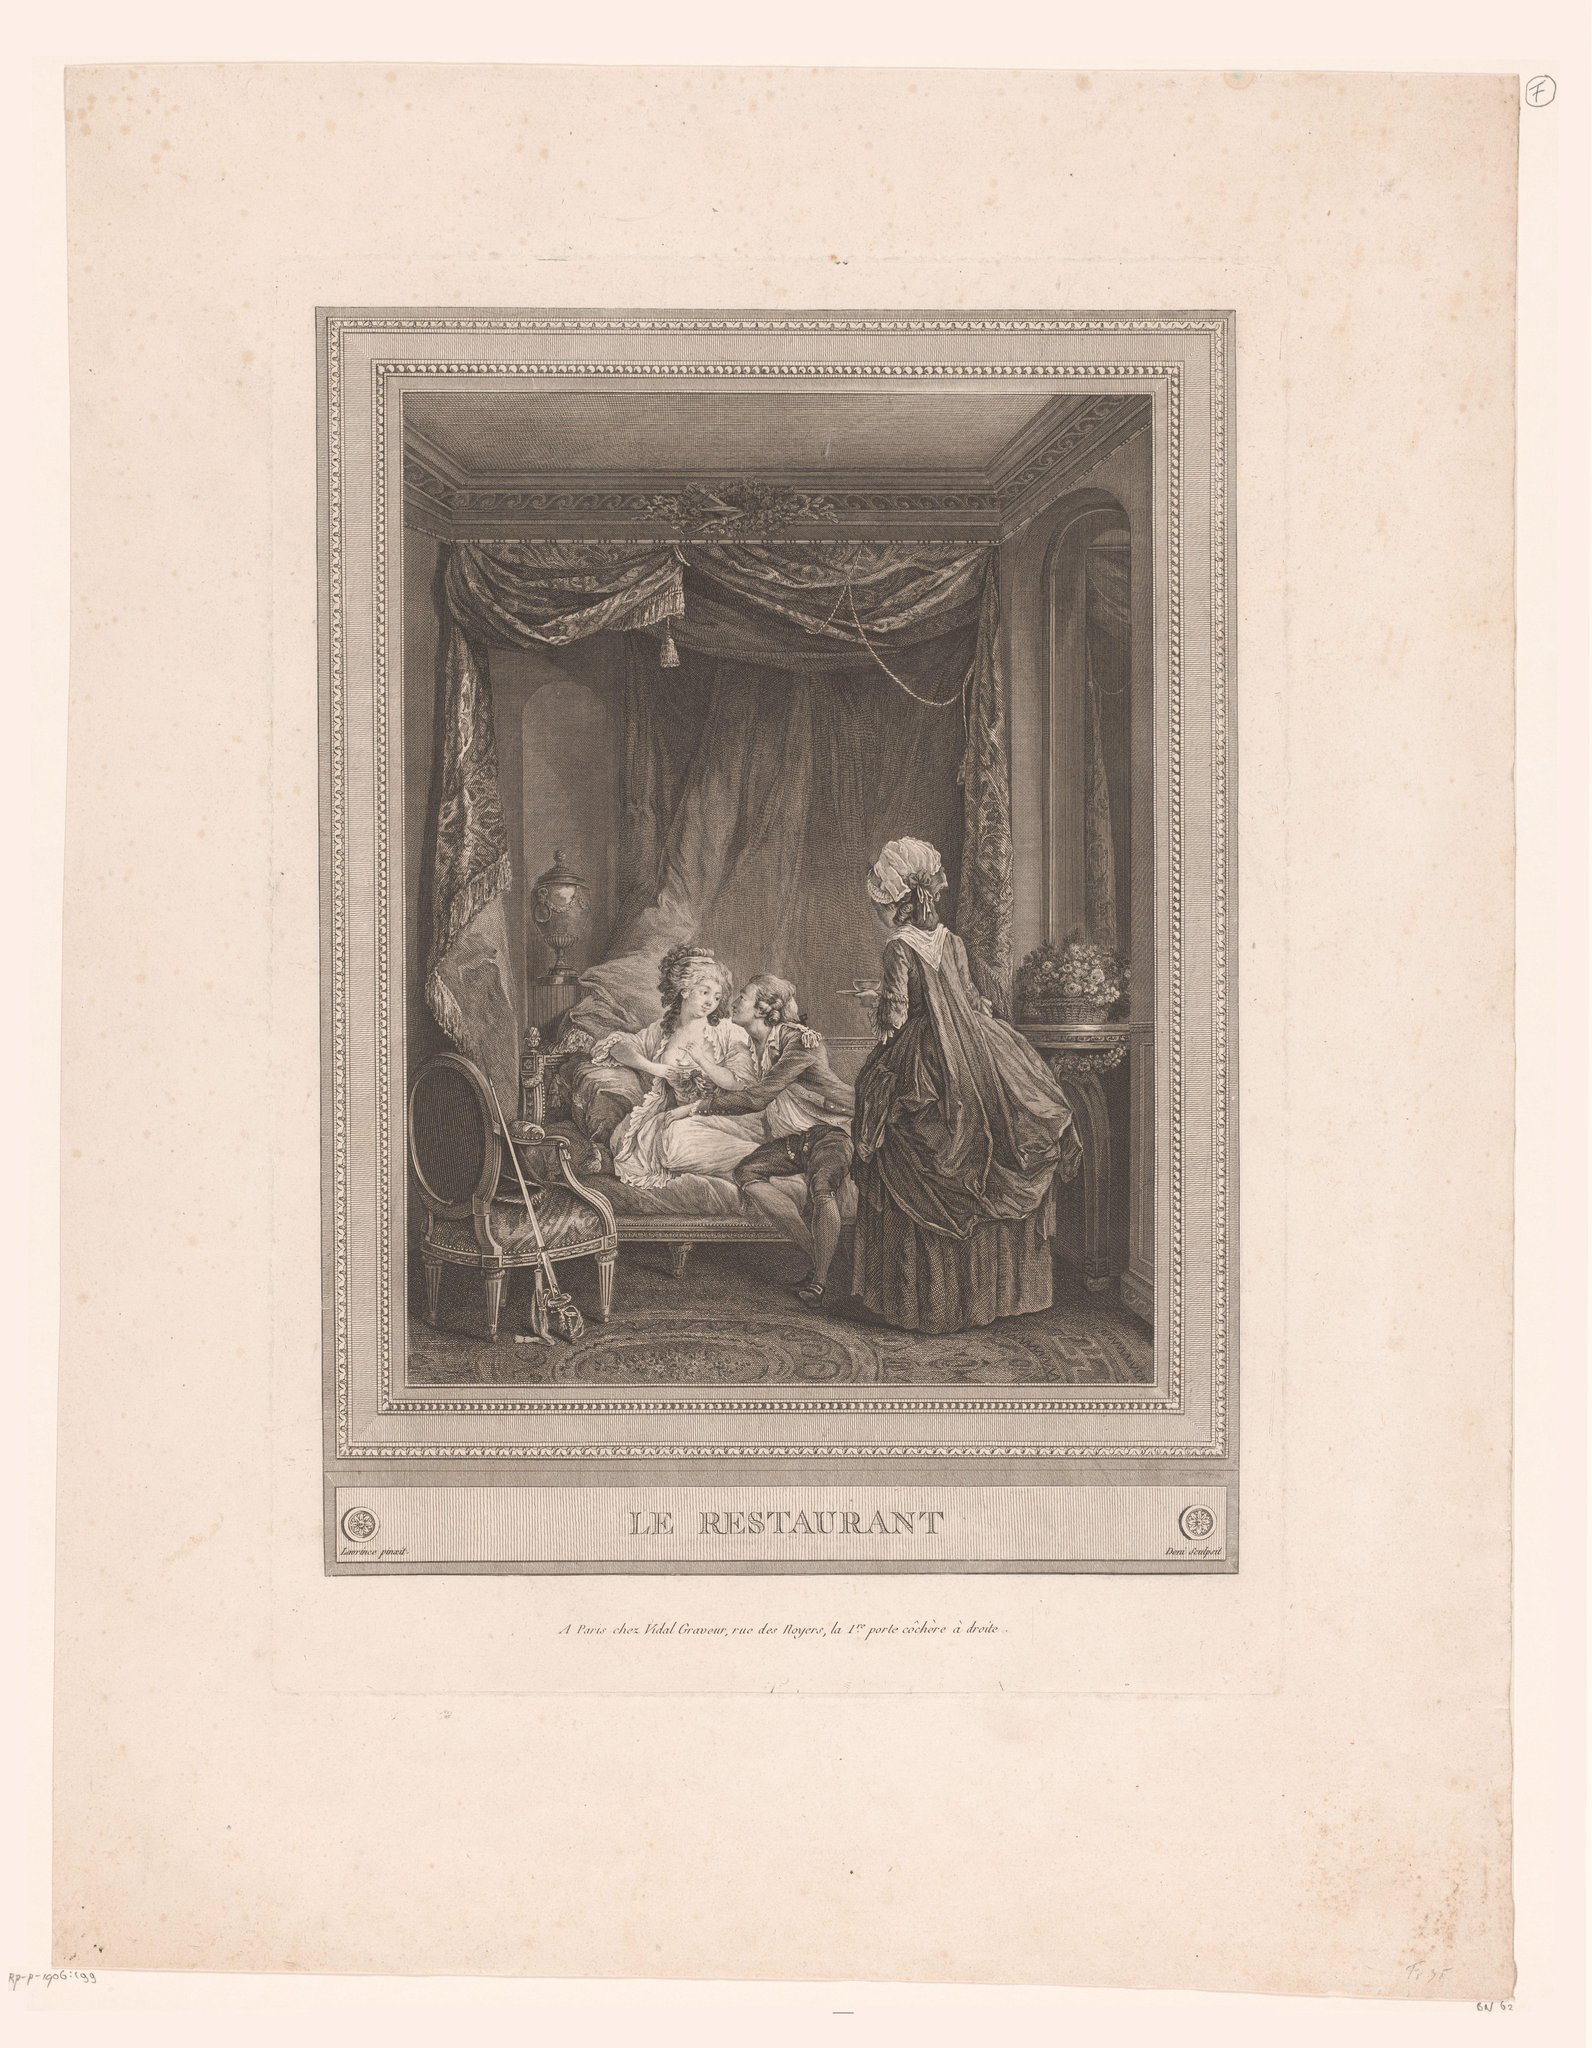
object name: print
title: Le restaurant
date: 1782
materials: paper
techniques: engraving, etching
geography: france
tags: canopy, baldachin, clothes, costume (+ women's clothes), clothes, costume (+ men's clothes), broth, soup, restaurant, lovers; courting, flirting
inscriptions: title: ‘LE RESTAURANT’, signature: ‘Deni sculpsit’, collector's mark: Lugt 2228, signature:, address: ‘A Paris chez Vidal Graveur, rue des Noyers, la 1ere porte cochëre a droite’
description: In een vertrek zit een jong paar op een canapé met baldakijn. De dame draagt een négligé en houdt een kop bouillon in haar hand. De heer omhelst haar. Voor het stel een vrouwelijke bediende, op de rug gezien, met eveneens een kop in haar hand.